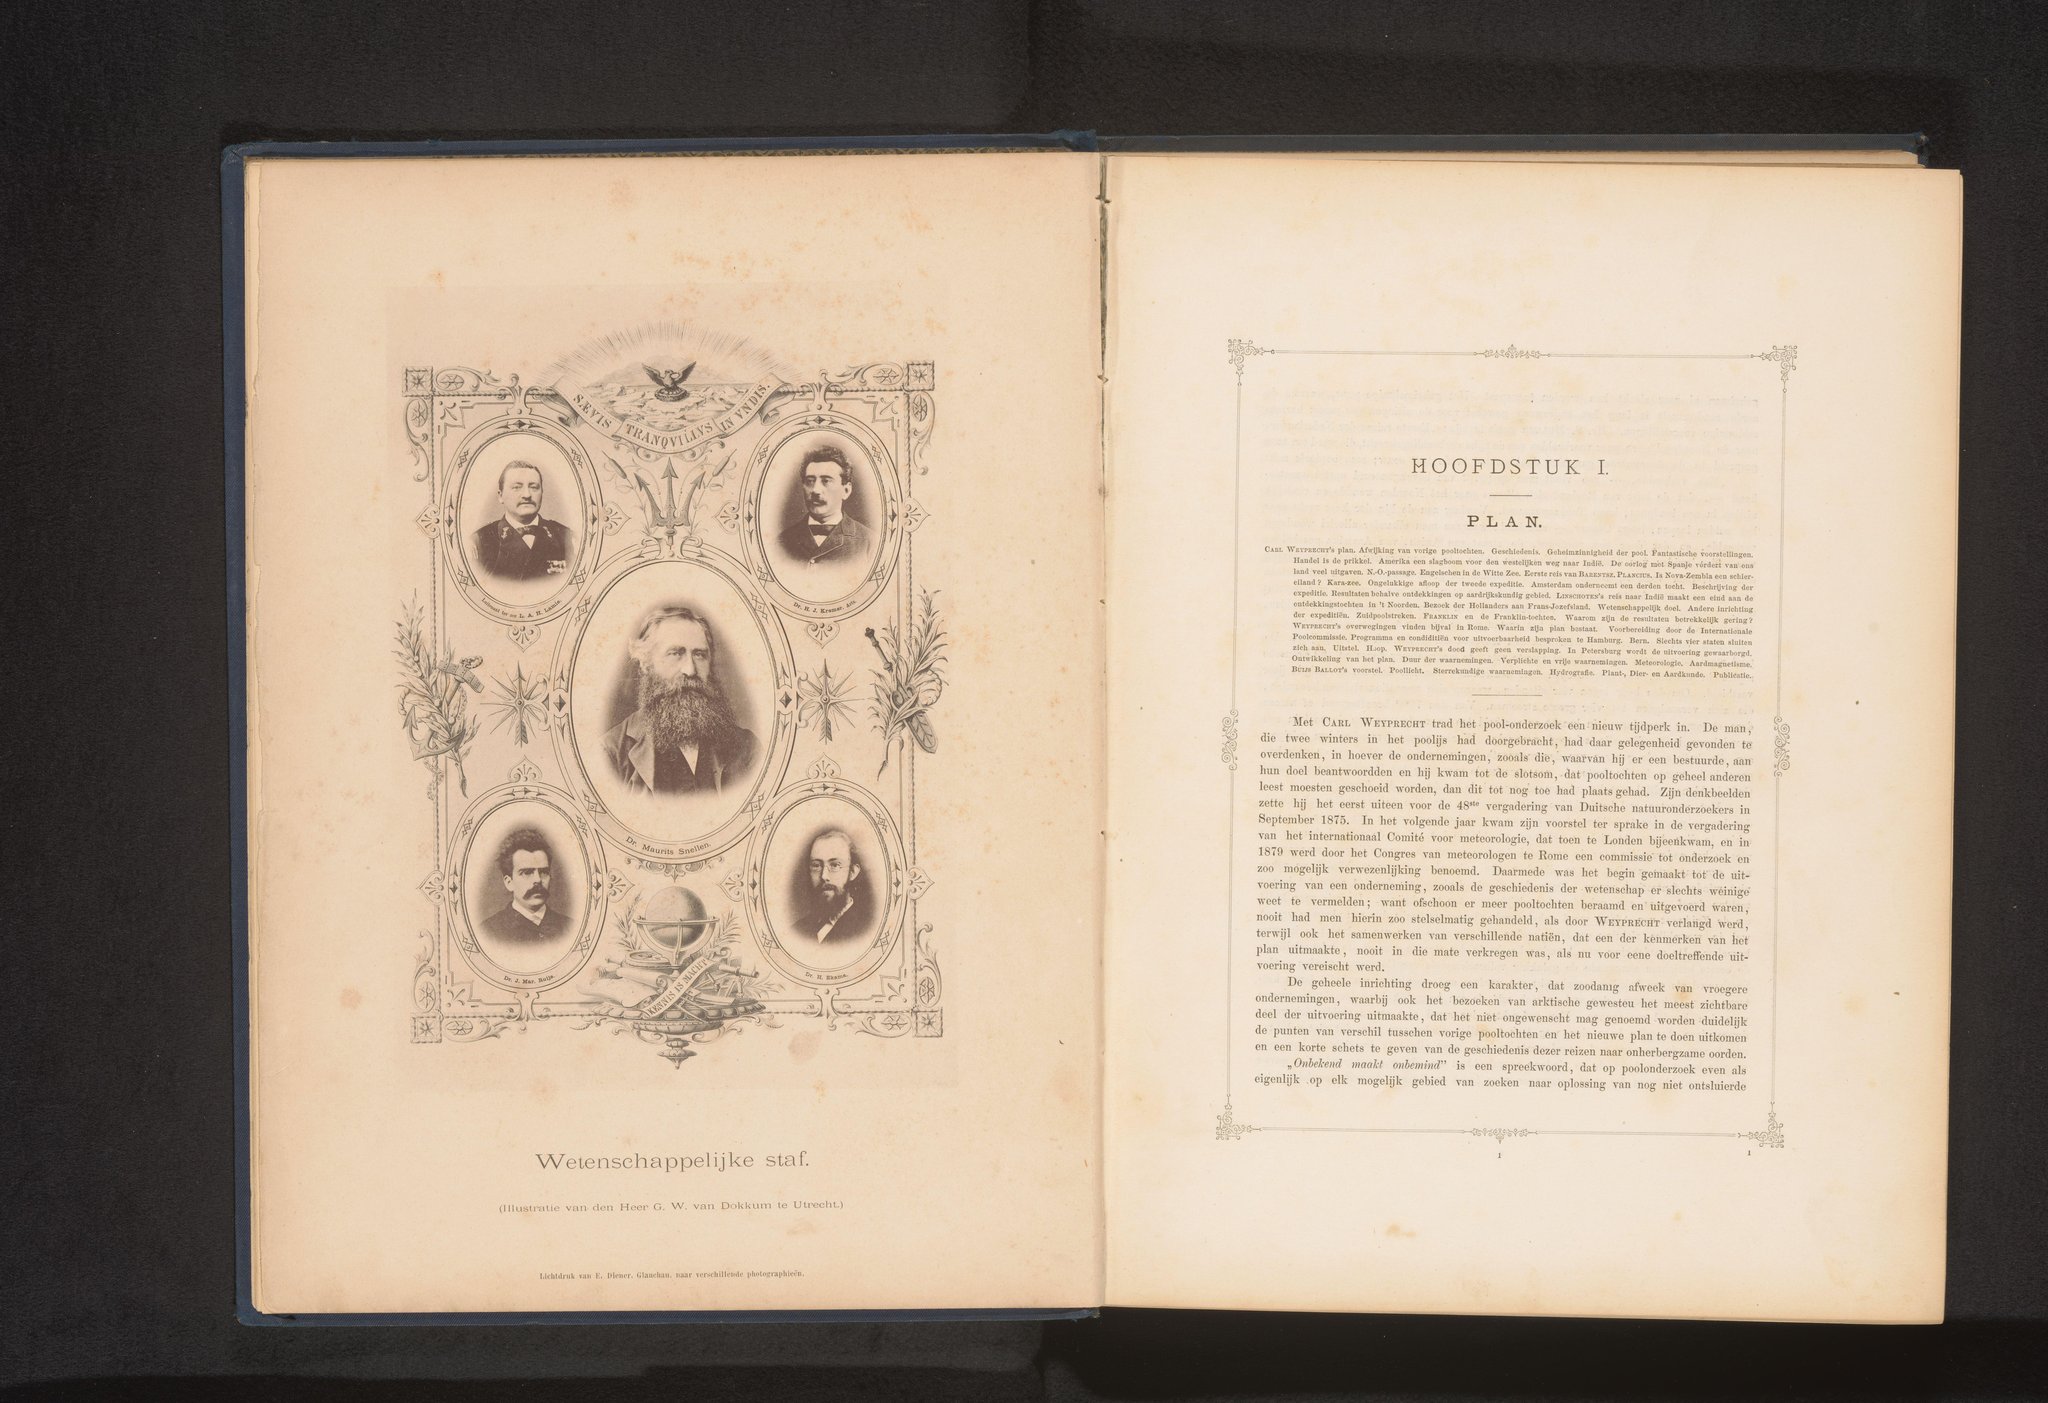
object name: page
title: Wetenschappelijke staf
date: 1881-1886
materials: paper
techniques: photograph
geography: glauchau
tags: nijmegen, zeist, maurits snellen, h. ekama, historical persons